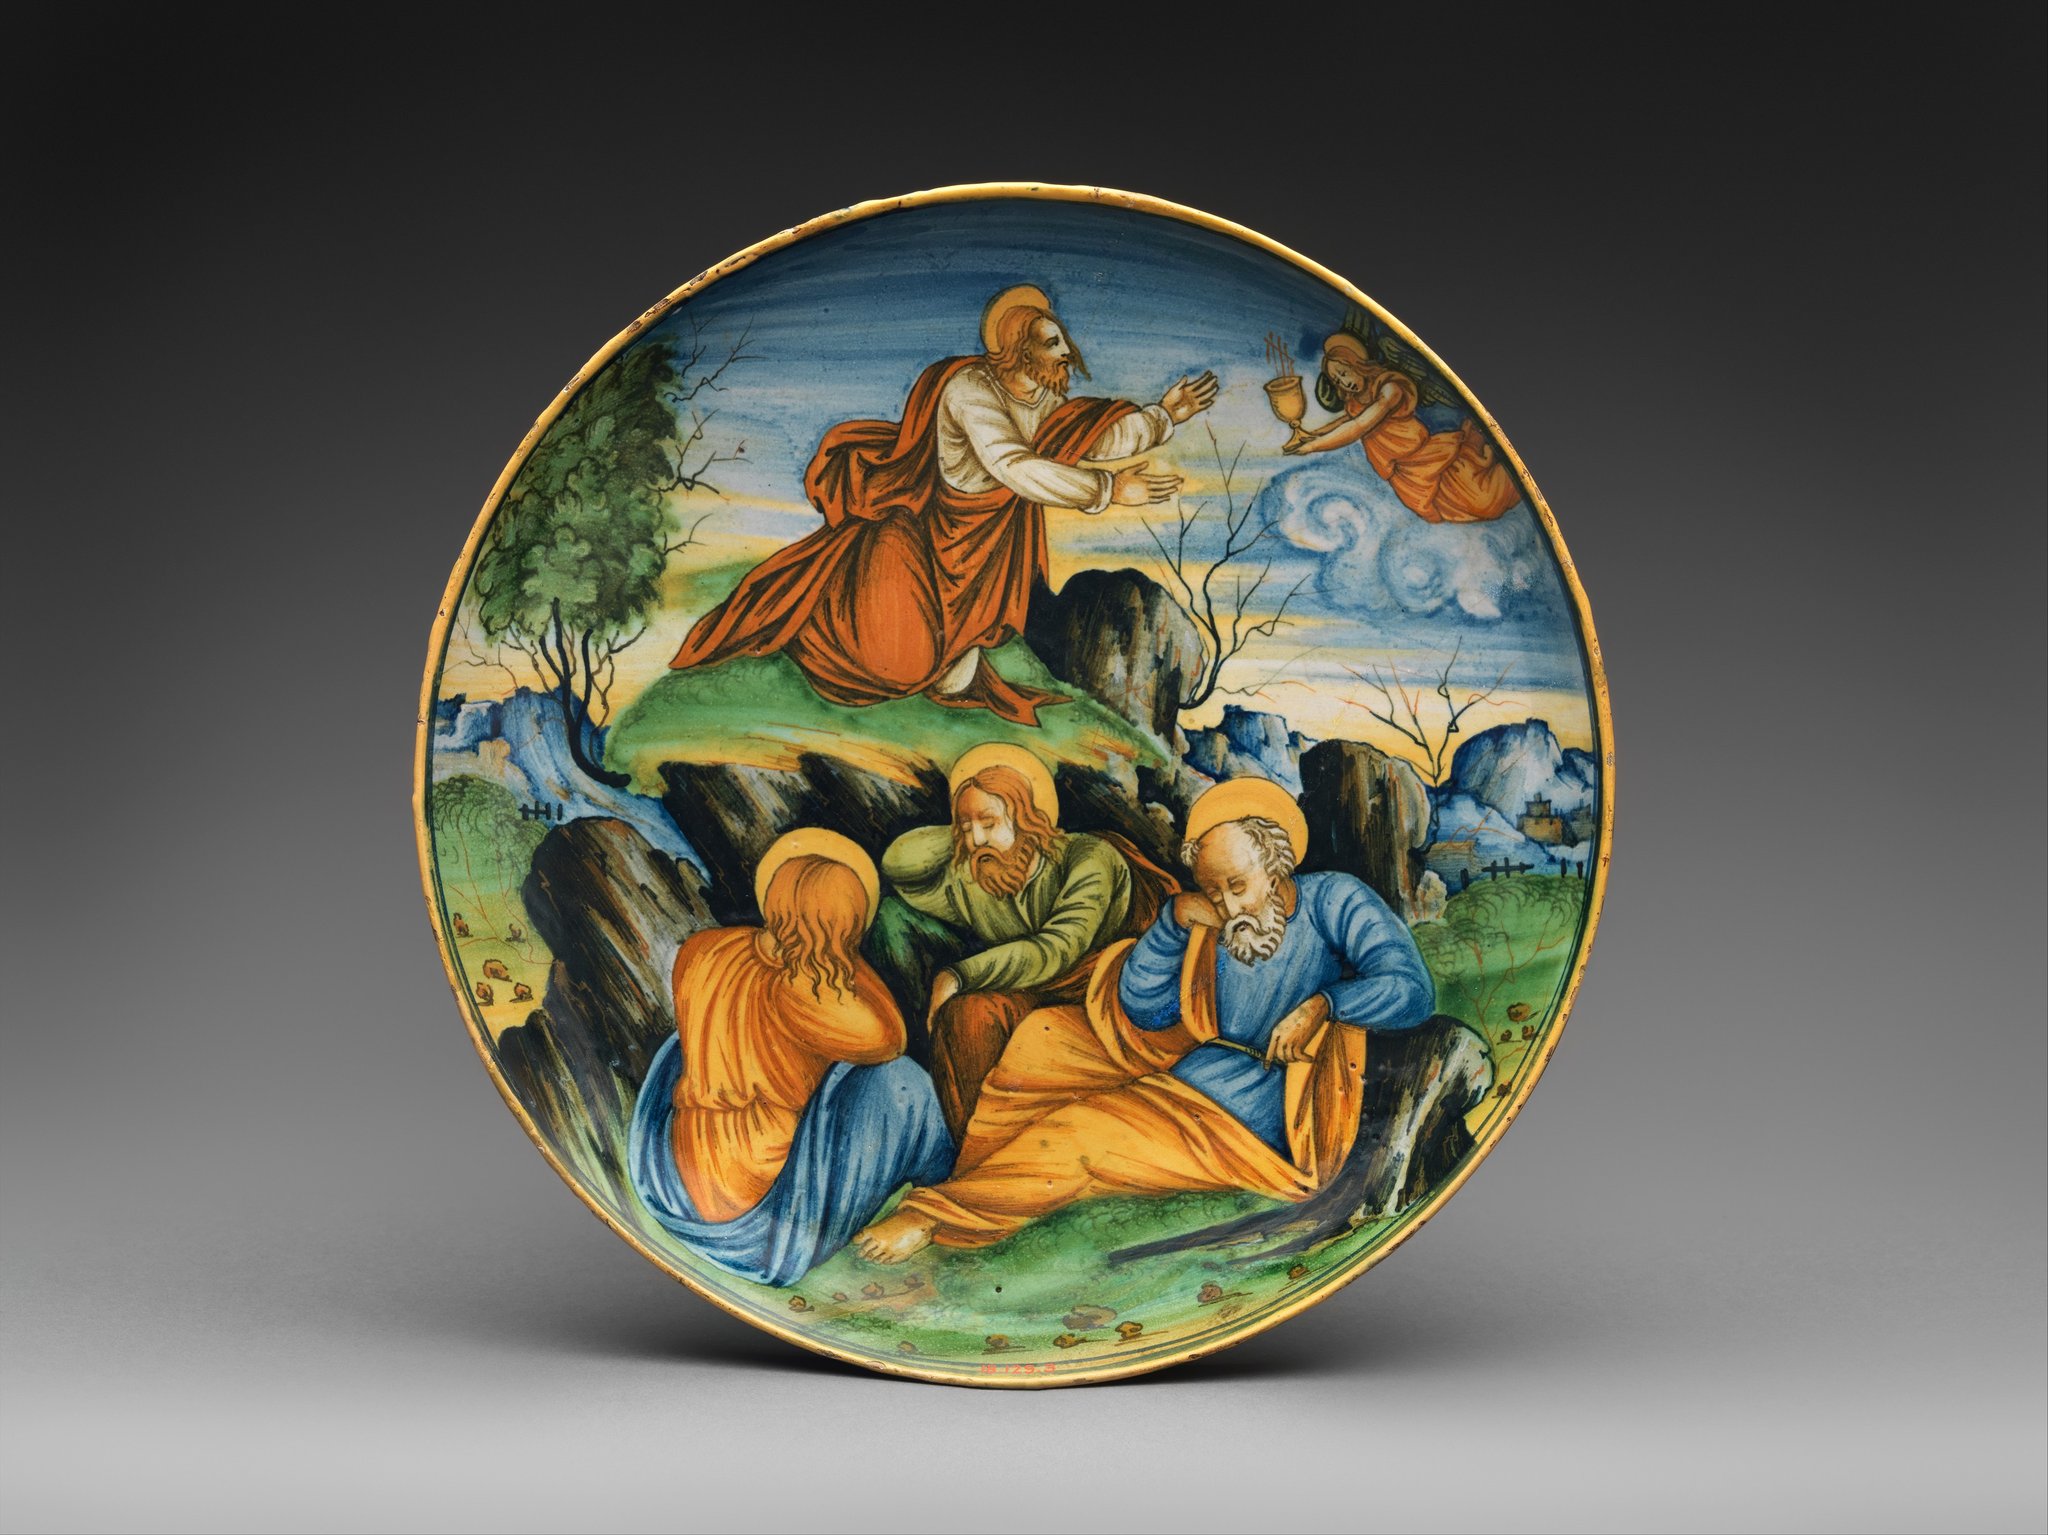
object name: bowl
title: Shallow bowl with The Agony in the Garden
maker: baldassare manara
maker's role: artist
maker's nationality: italian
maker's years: 1500-1550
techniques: maiolica, glazing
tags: men,angels,jesus